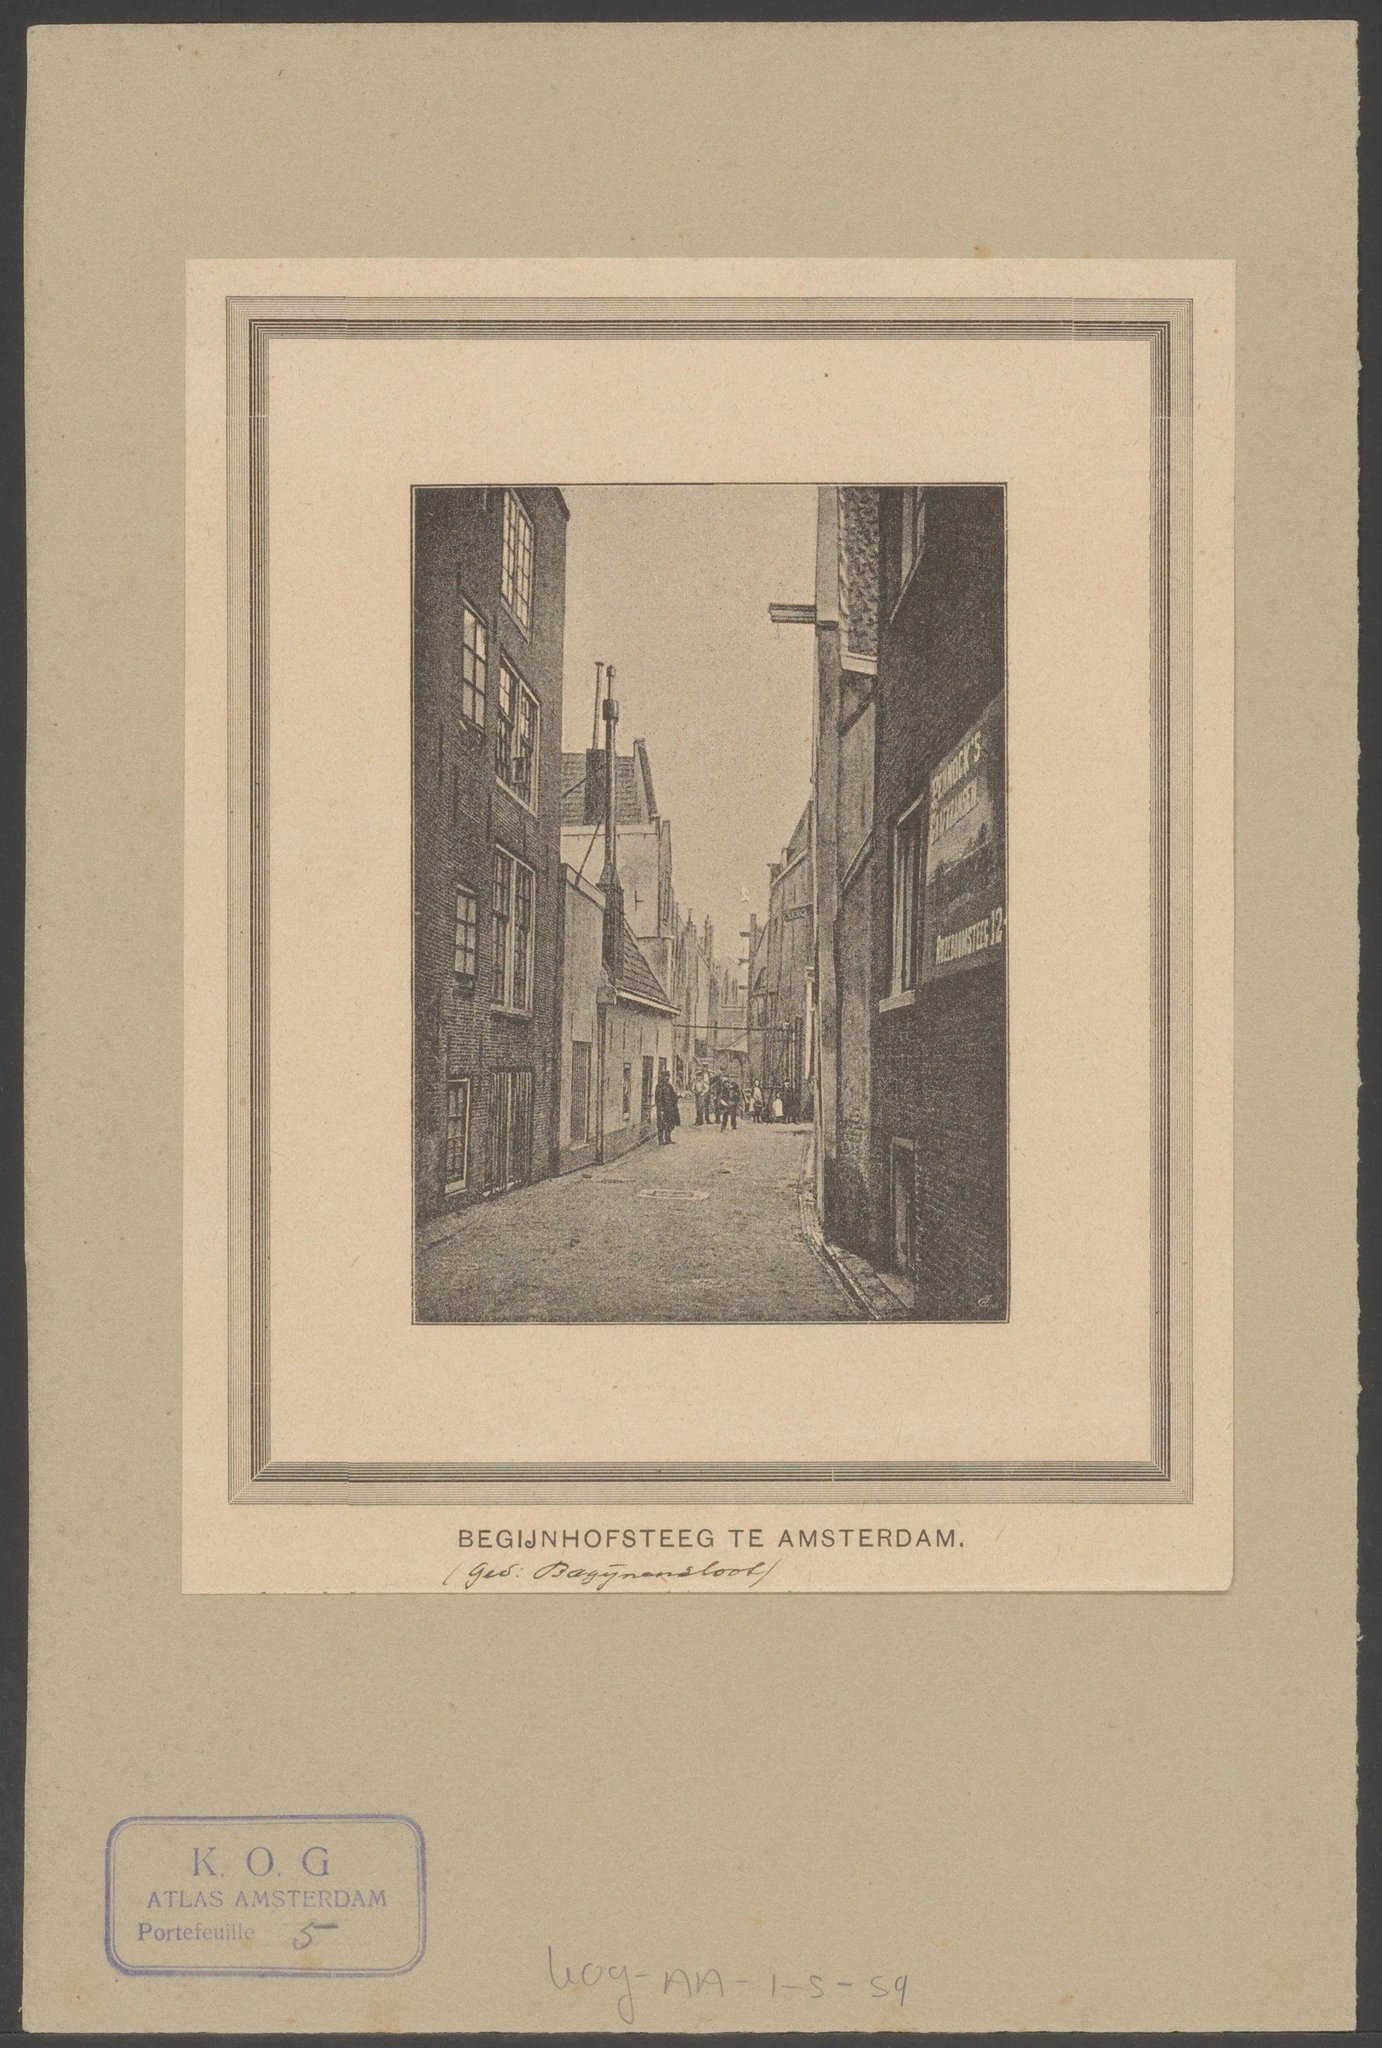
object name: photomechanical print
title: Gezicht op de Begijnhofsteeg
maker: Anonymous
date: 1882-1950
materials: paper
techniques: letterpress printing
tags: city-view in general; 'veduta', the usual house or row of houses, lane, alley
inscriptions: collector's mark: ‘5’ Lugt 1641b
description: Onderwerpsrubriek binnen de Atlas Amsterdam: Begijnensloot (Gedempte), Bagijnhofsteeg, Beulingsloot, Bickersgracht en –plein, Bickersstraat (Groote), Bilderdijkskade en -straat, Binnenkant, Blauwburgwal, Boomdwarsstraat, Brouwersgracht, Bleekersspad (Lange), Bleekerssloot, Bloemgracht, Boerenwetering, Boltensgrachtje, Boomssloot (Recht), Badhuisweg.